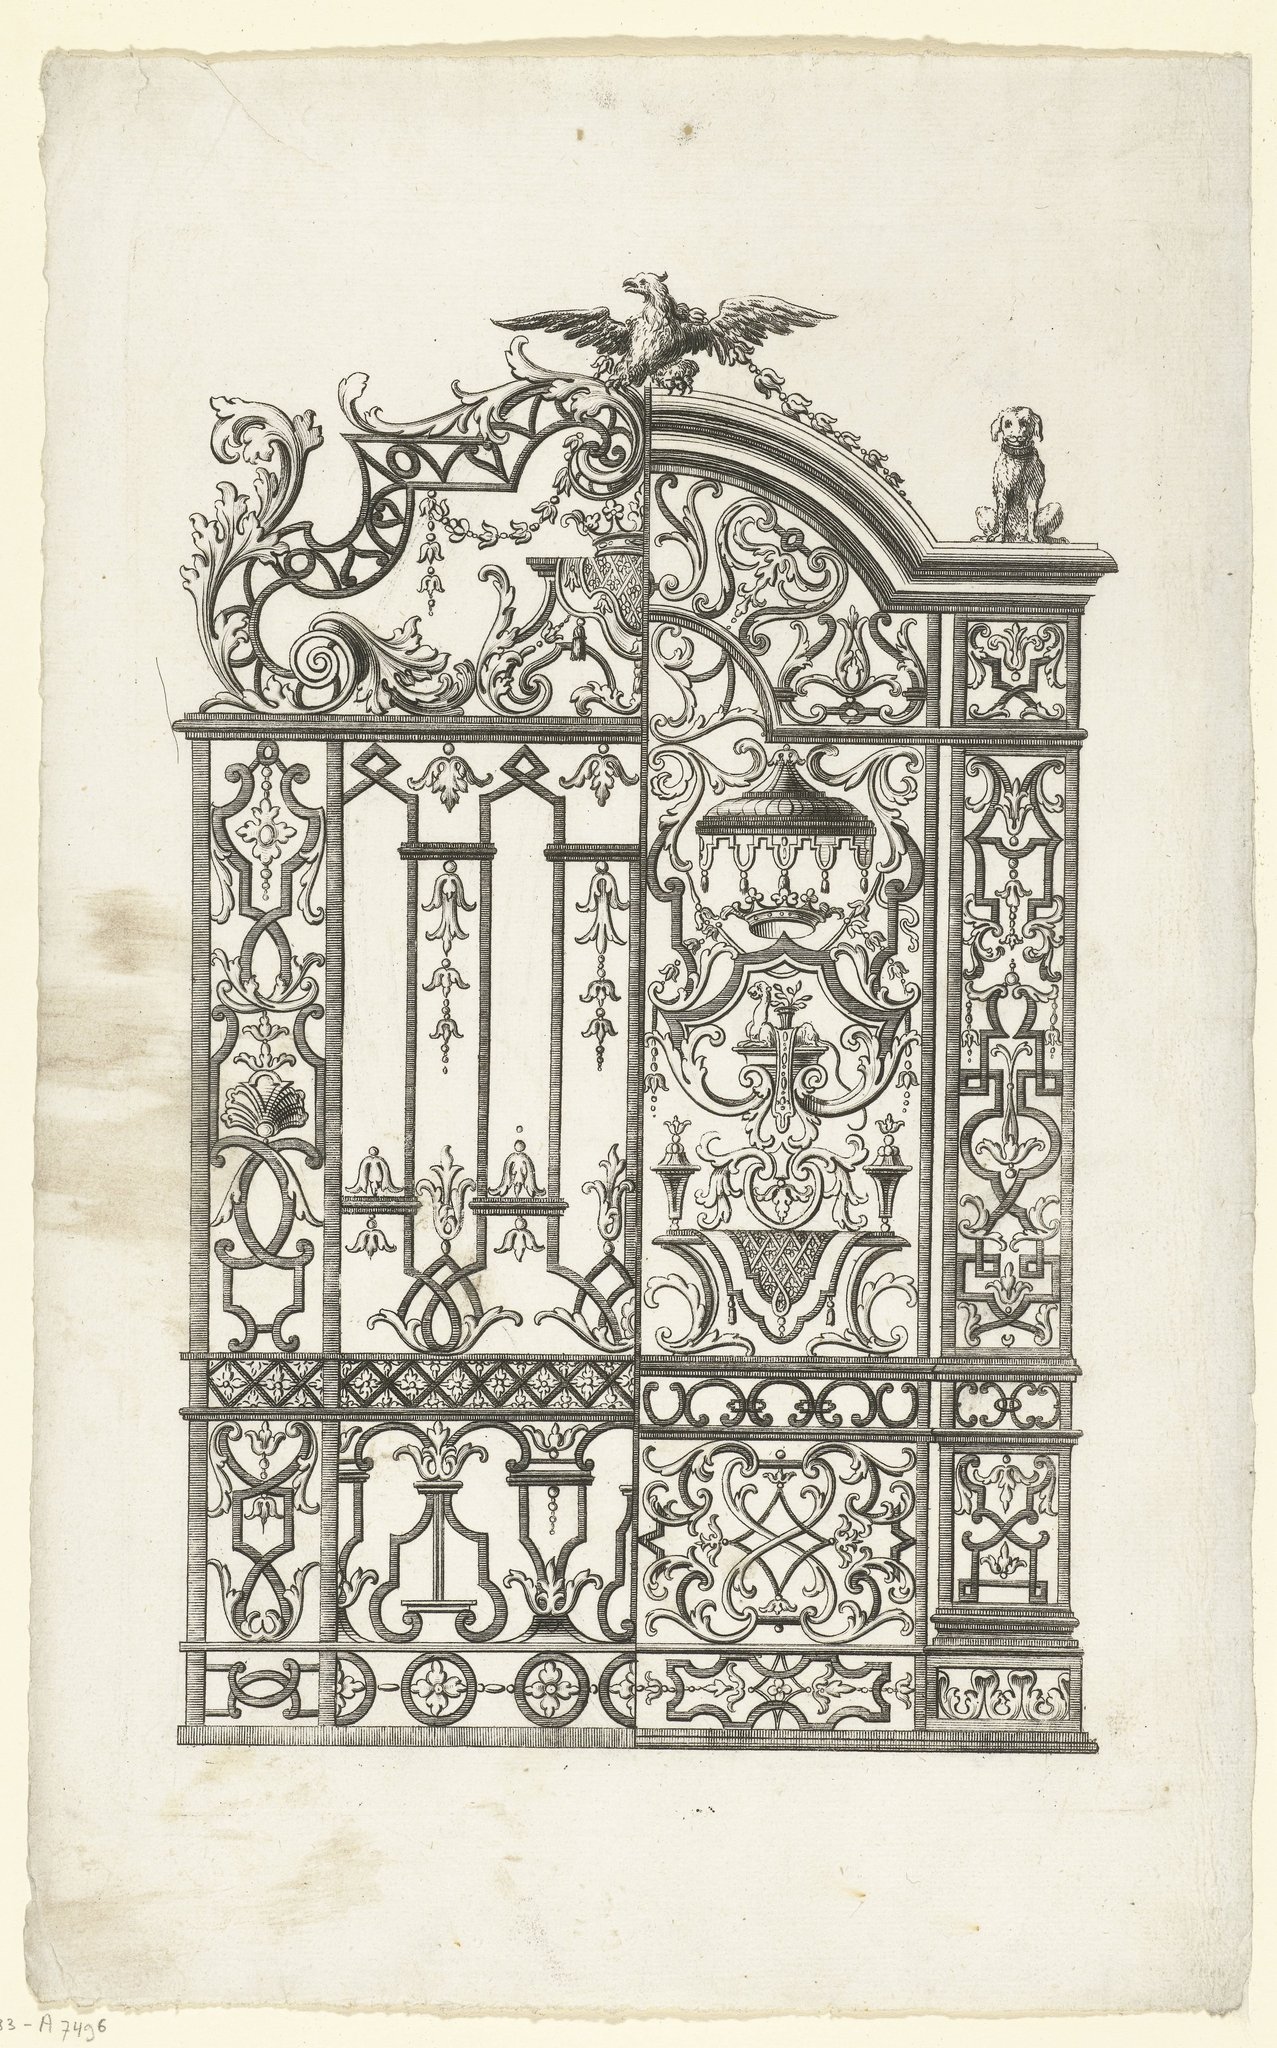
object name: ornament print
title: Rolwerk met bladranken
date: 1600-1699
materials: paper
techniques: etching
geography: germany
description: Met een variant aan de rechterhelft. Bovenaan zit een adelaar met een guirlande om zich heen, rechtsboven zit een hond.